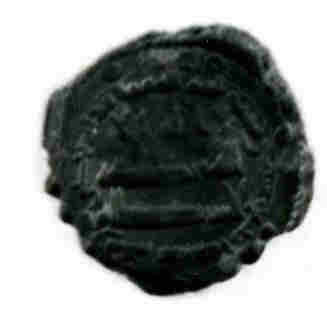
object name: coin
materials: copper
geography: iran